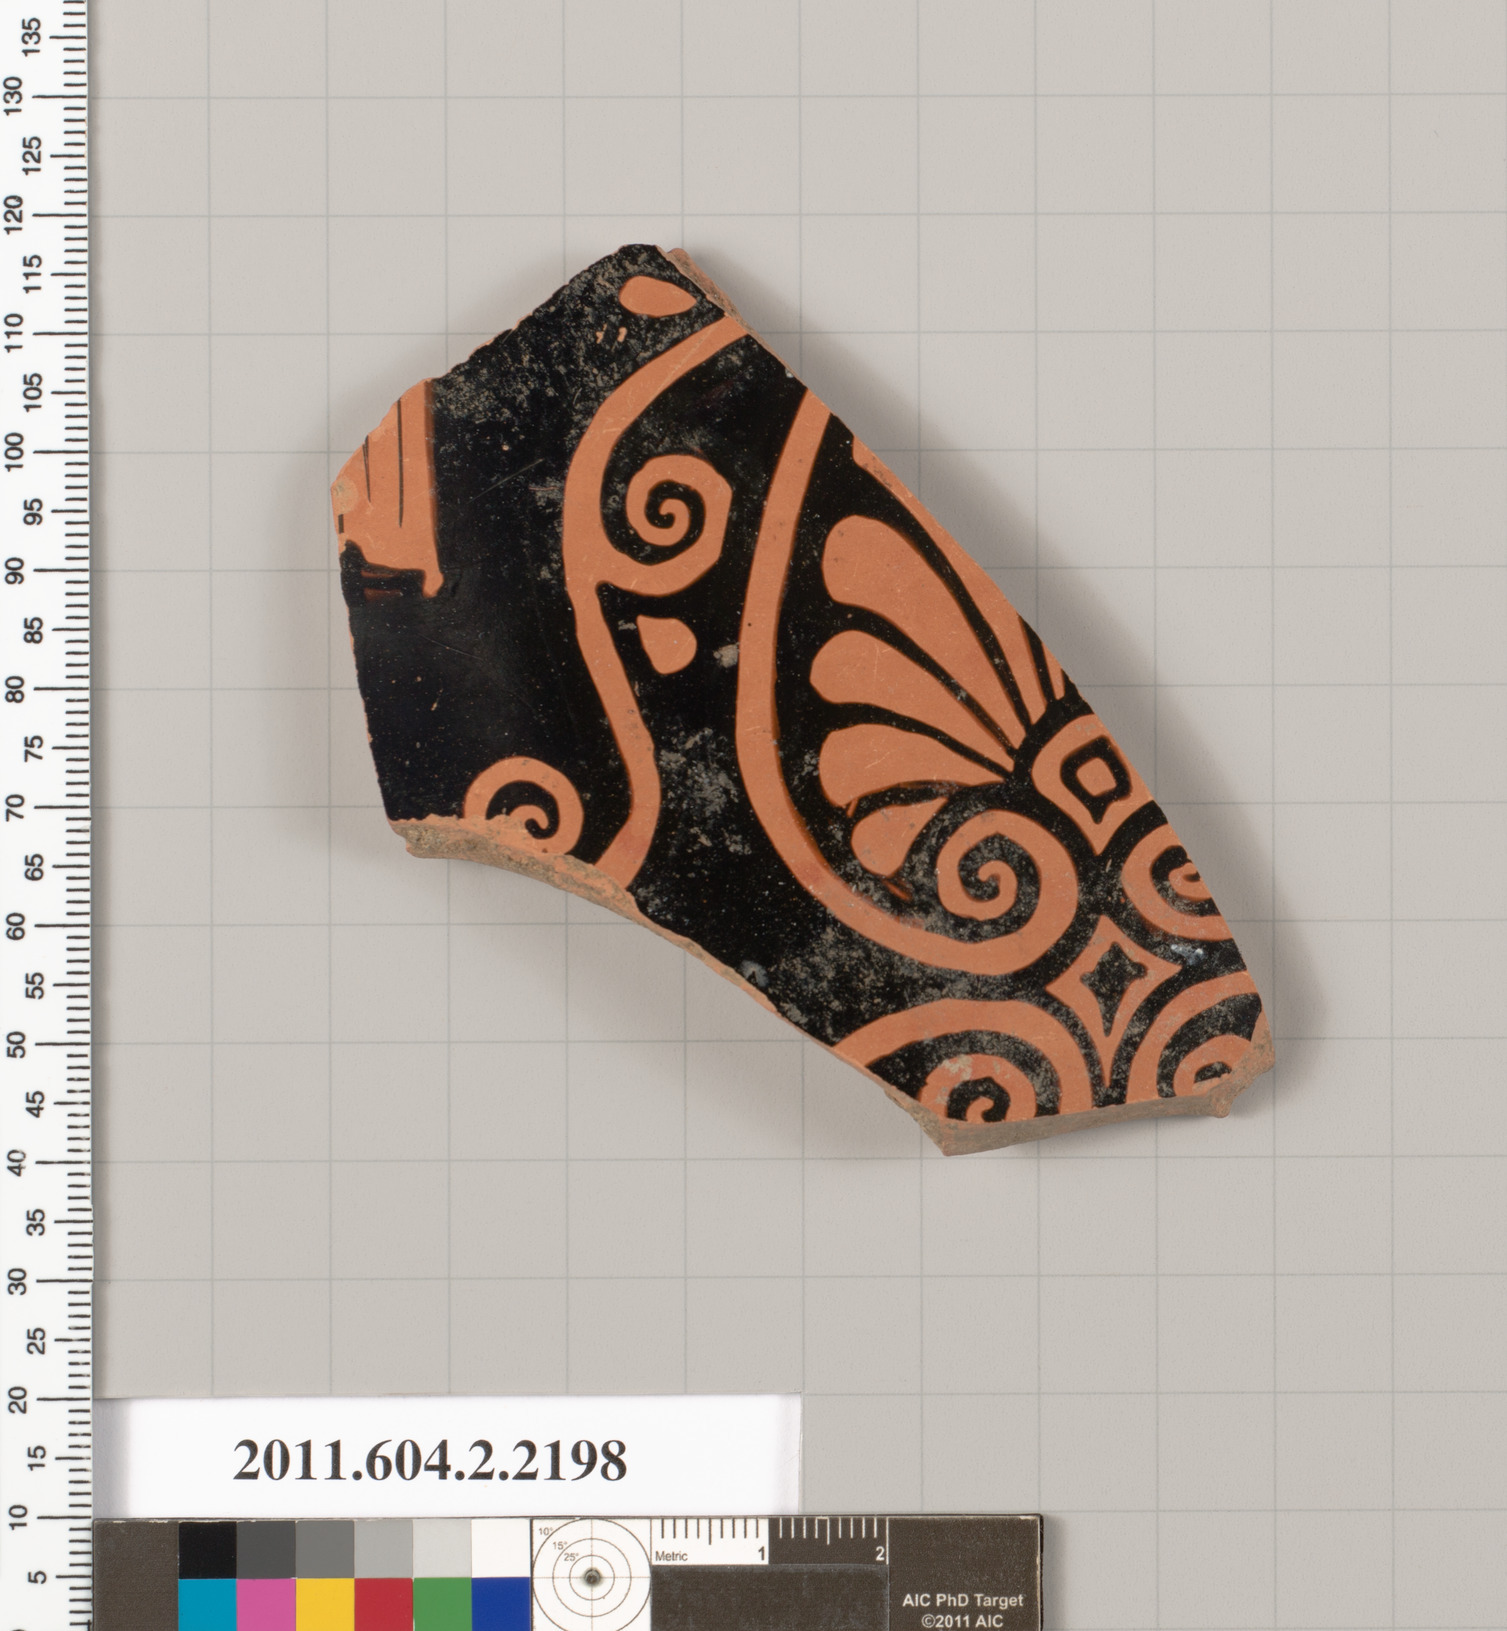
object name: pot fragment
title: Terracotta fragment of a pot; unglazed on the inside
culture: greek, attic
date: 450-426 BCE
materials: terracotta